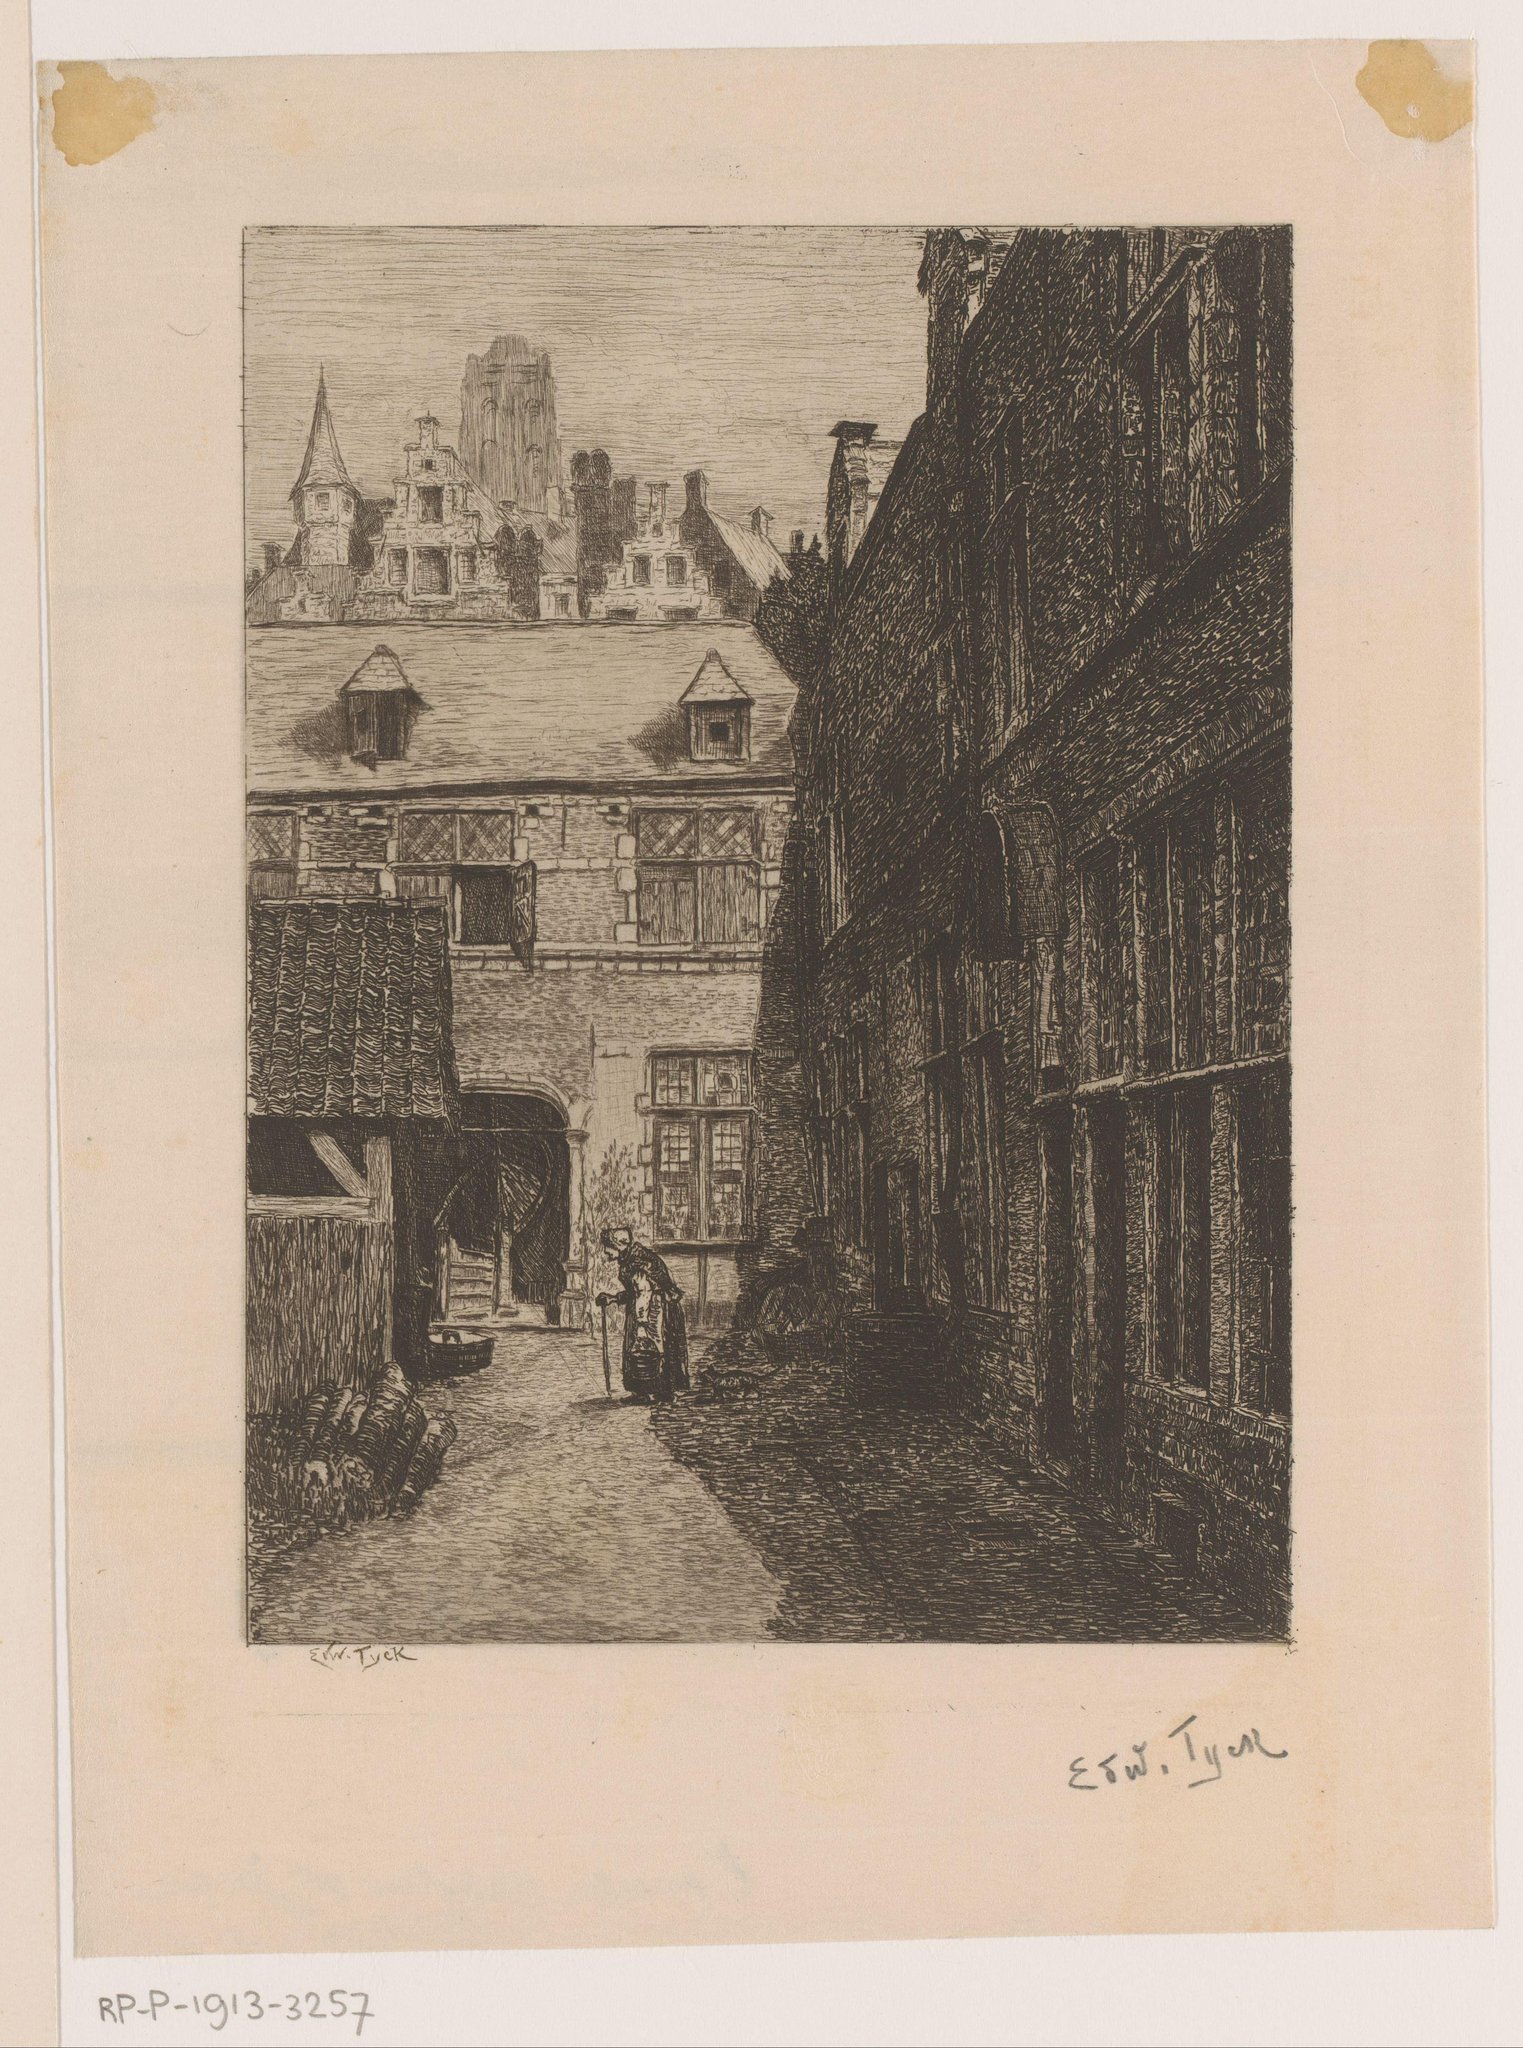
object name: print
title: Straatgezicht met toren van de Sint-Jacobskerk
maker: edouard tyck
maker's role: print maker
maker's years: 1847-1922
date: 1880-1913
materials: paper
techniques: drypoint, etching, intaglio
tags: city-view in general; 'veduta', parts of church exterior and annexes: tower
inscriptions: annotation: ‘L'ancien quartier st Jacques/ Anvers’, workshop stamp: ‘Antwerpsche Etsers 1880’, collector's mark: Lugt 2228